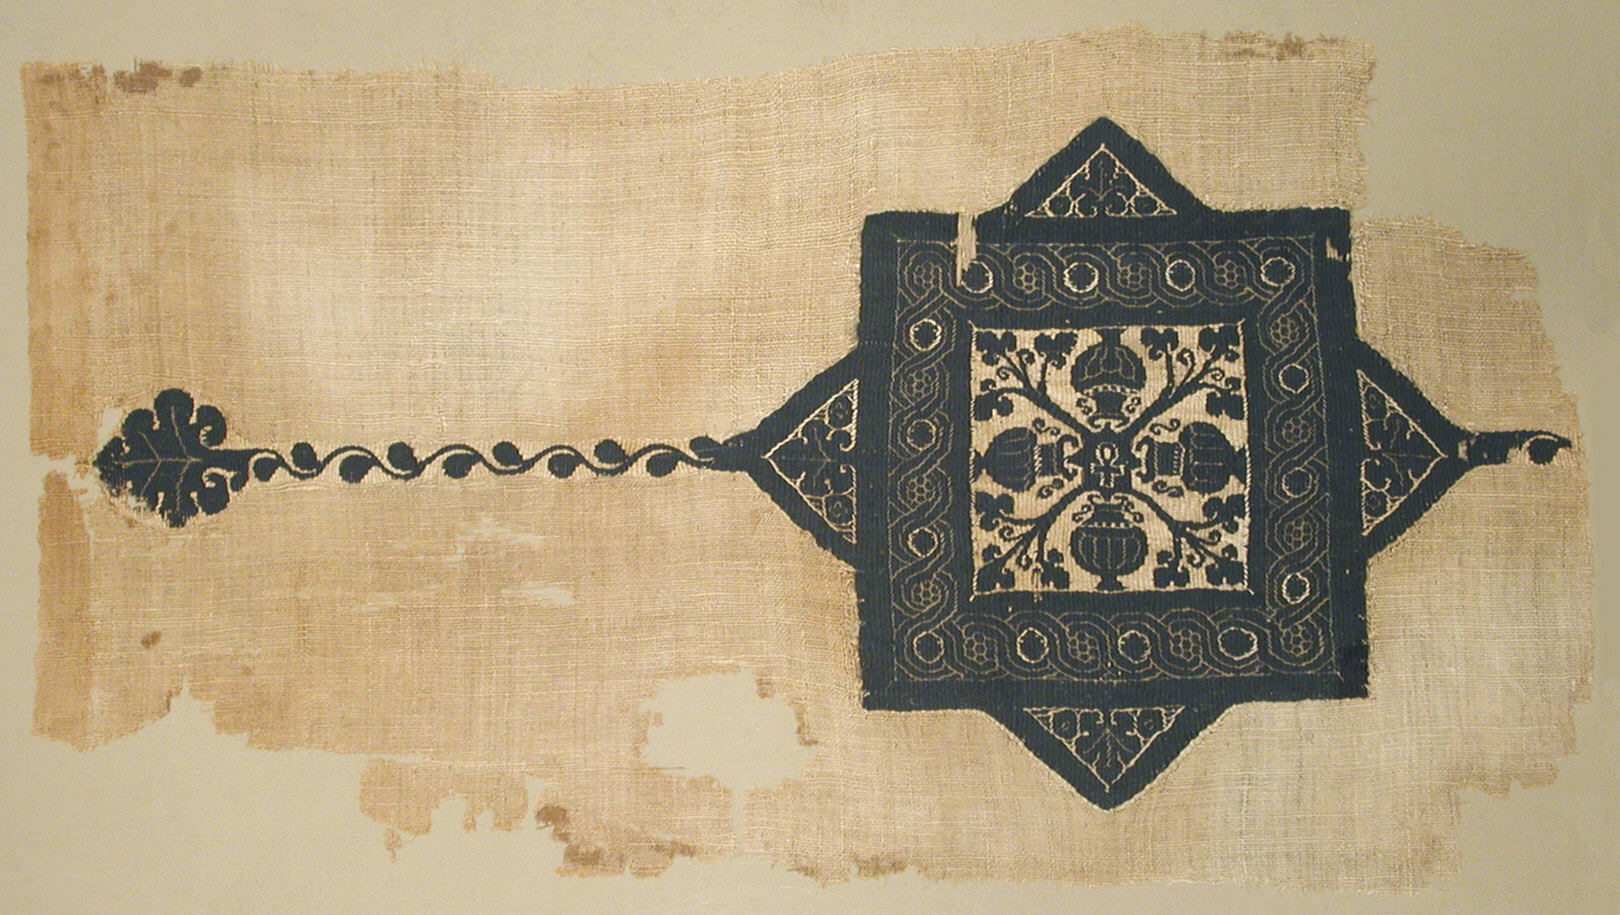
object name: textile fragment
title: Coptic Textile Fragment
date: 267-500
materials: linen, wool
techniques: brocade, weave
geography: egypt